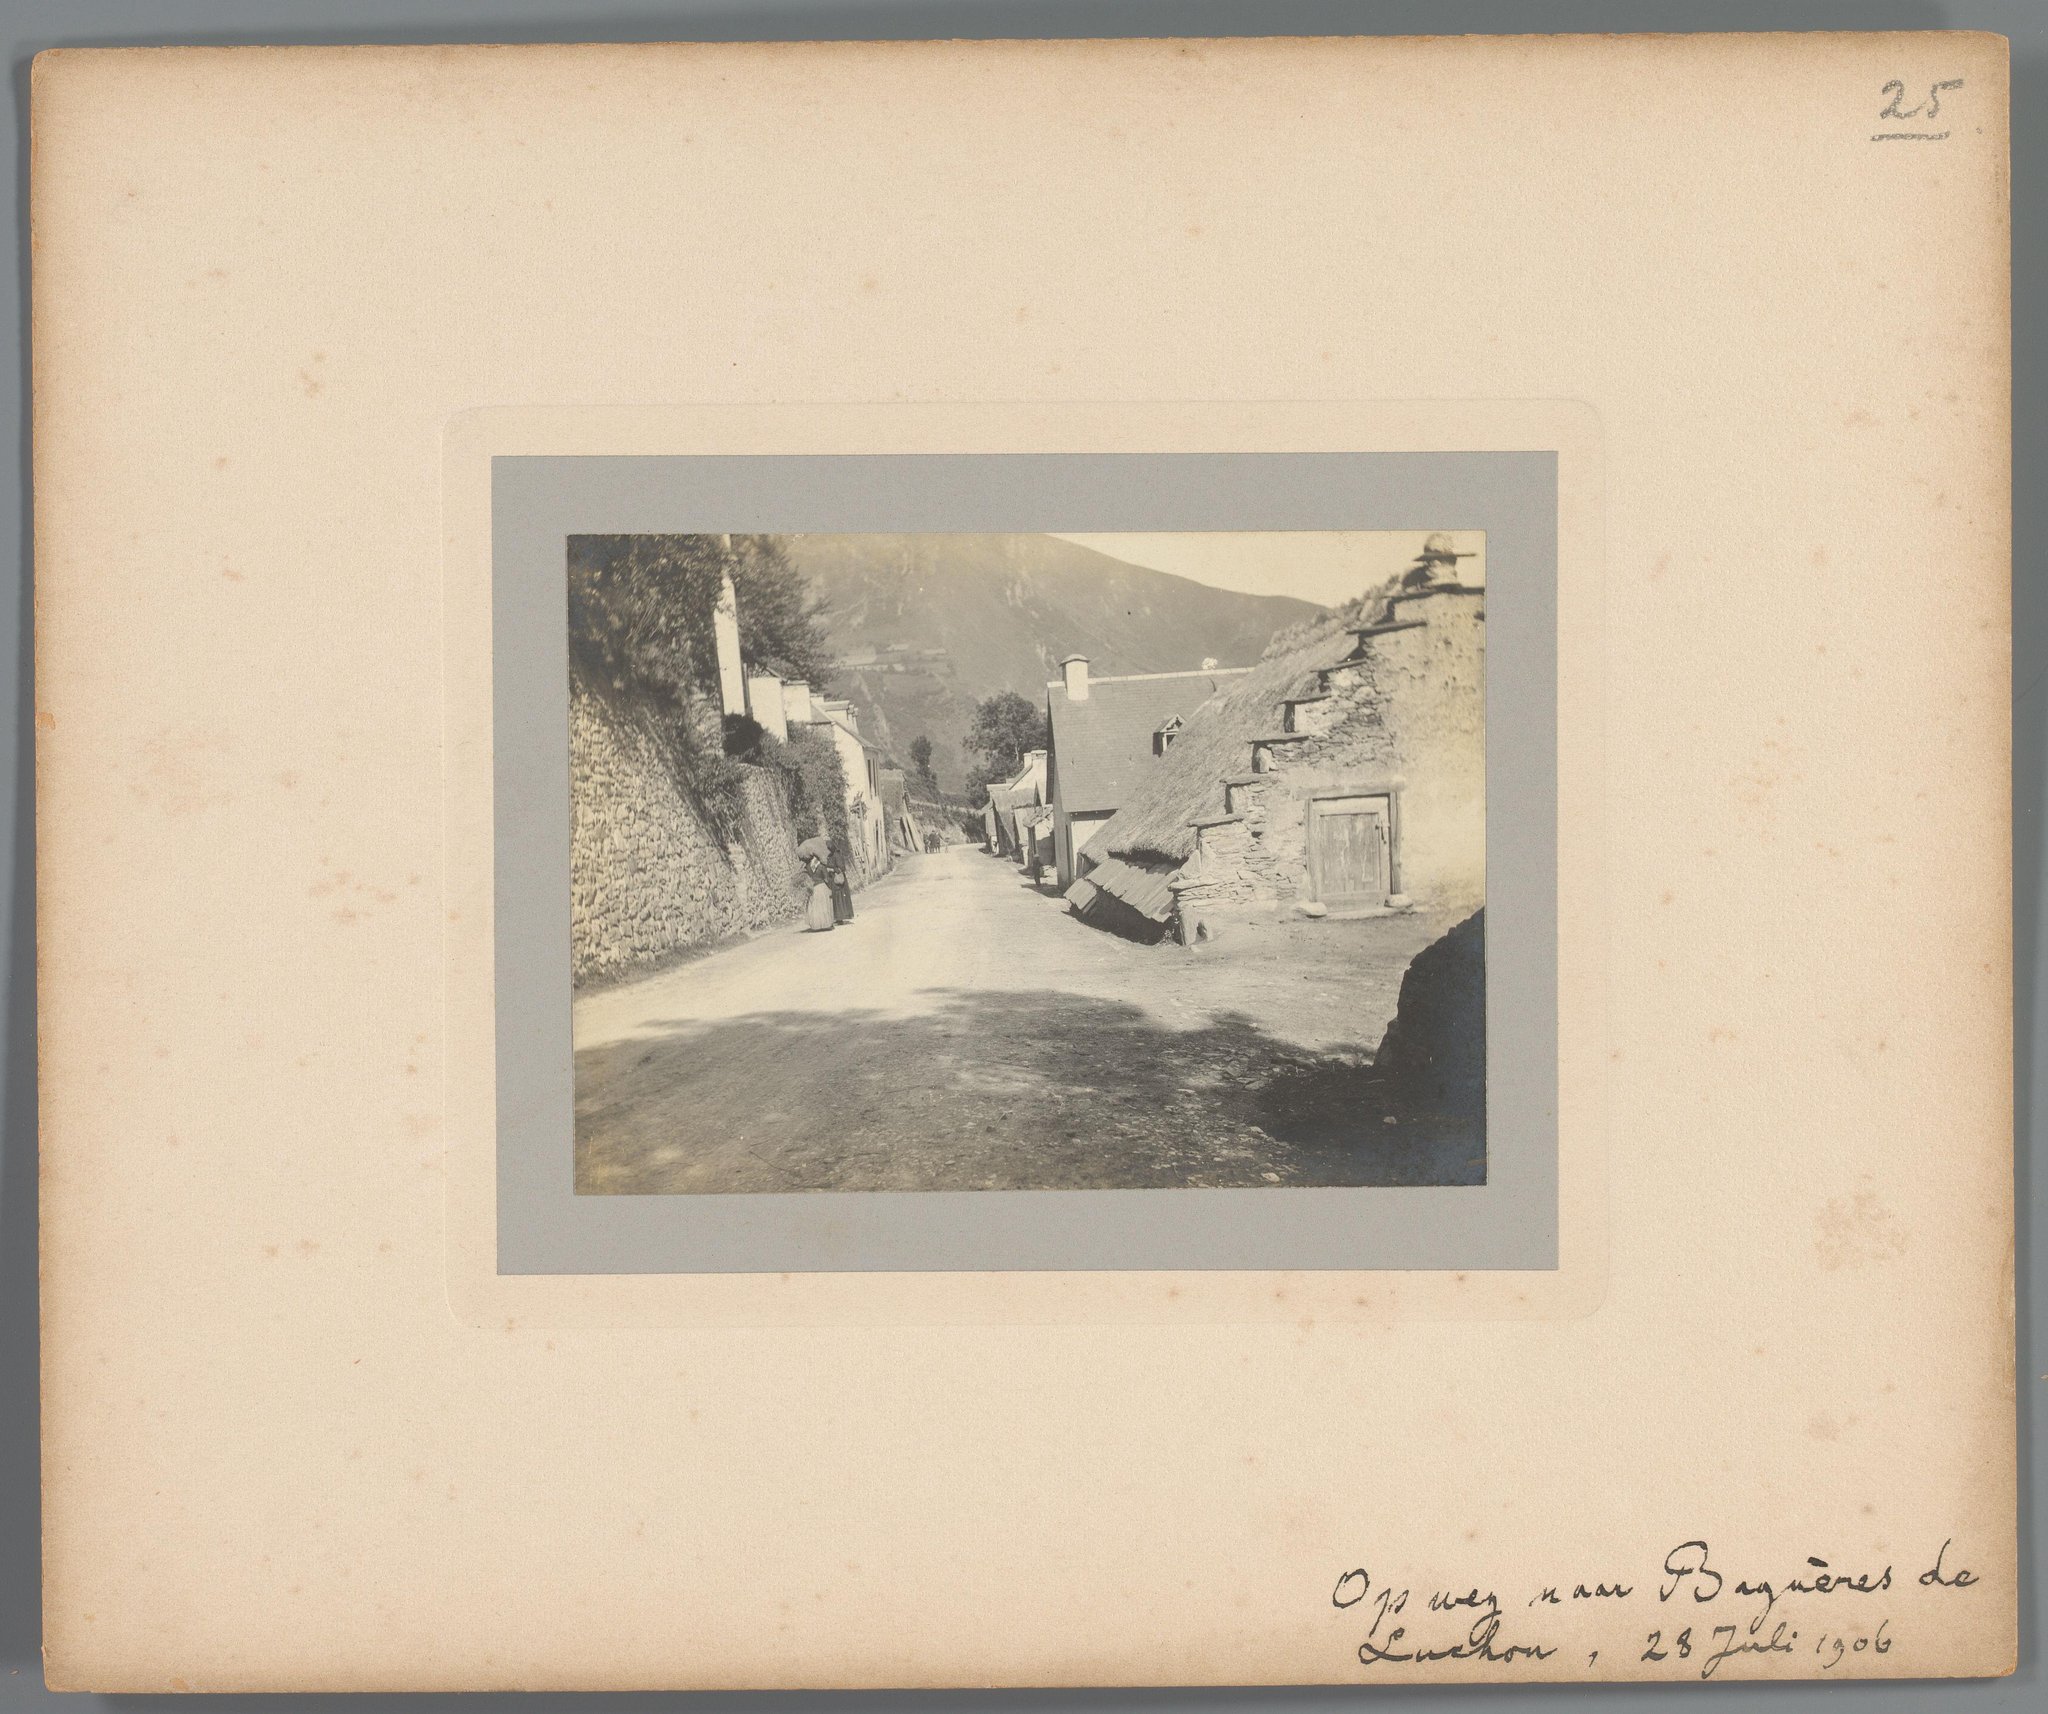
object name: photograph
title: Op weg naar Bagnères de Luchon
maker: françois buys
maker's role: advocaat, amateurfotograaf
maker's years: 1871-1934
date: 1906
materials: paper, cardboard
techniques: gelatin silver print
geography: haute-garonne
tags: village, road, path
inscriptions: number: ‘25’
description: Deze foto maakt deel uit van een groep van 49 foto's.